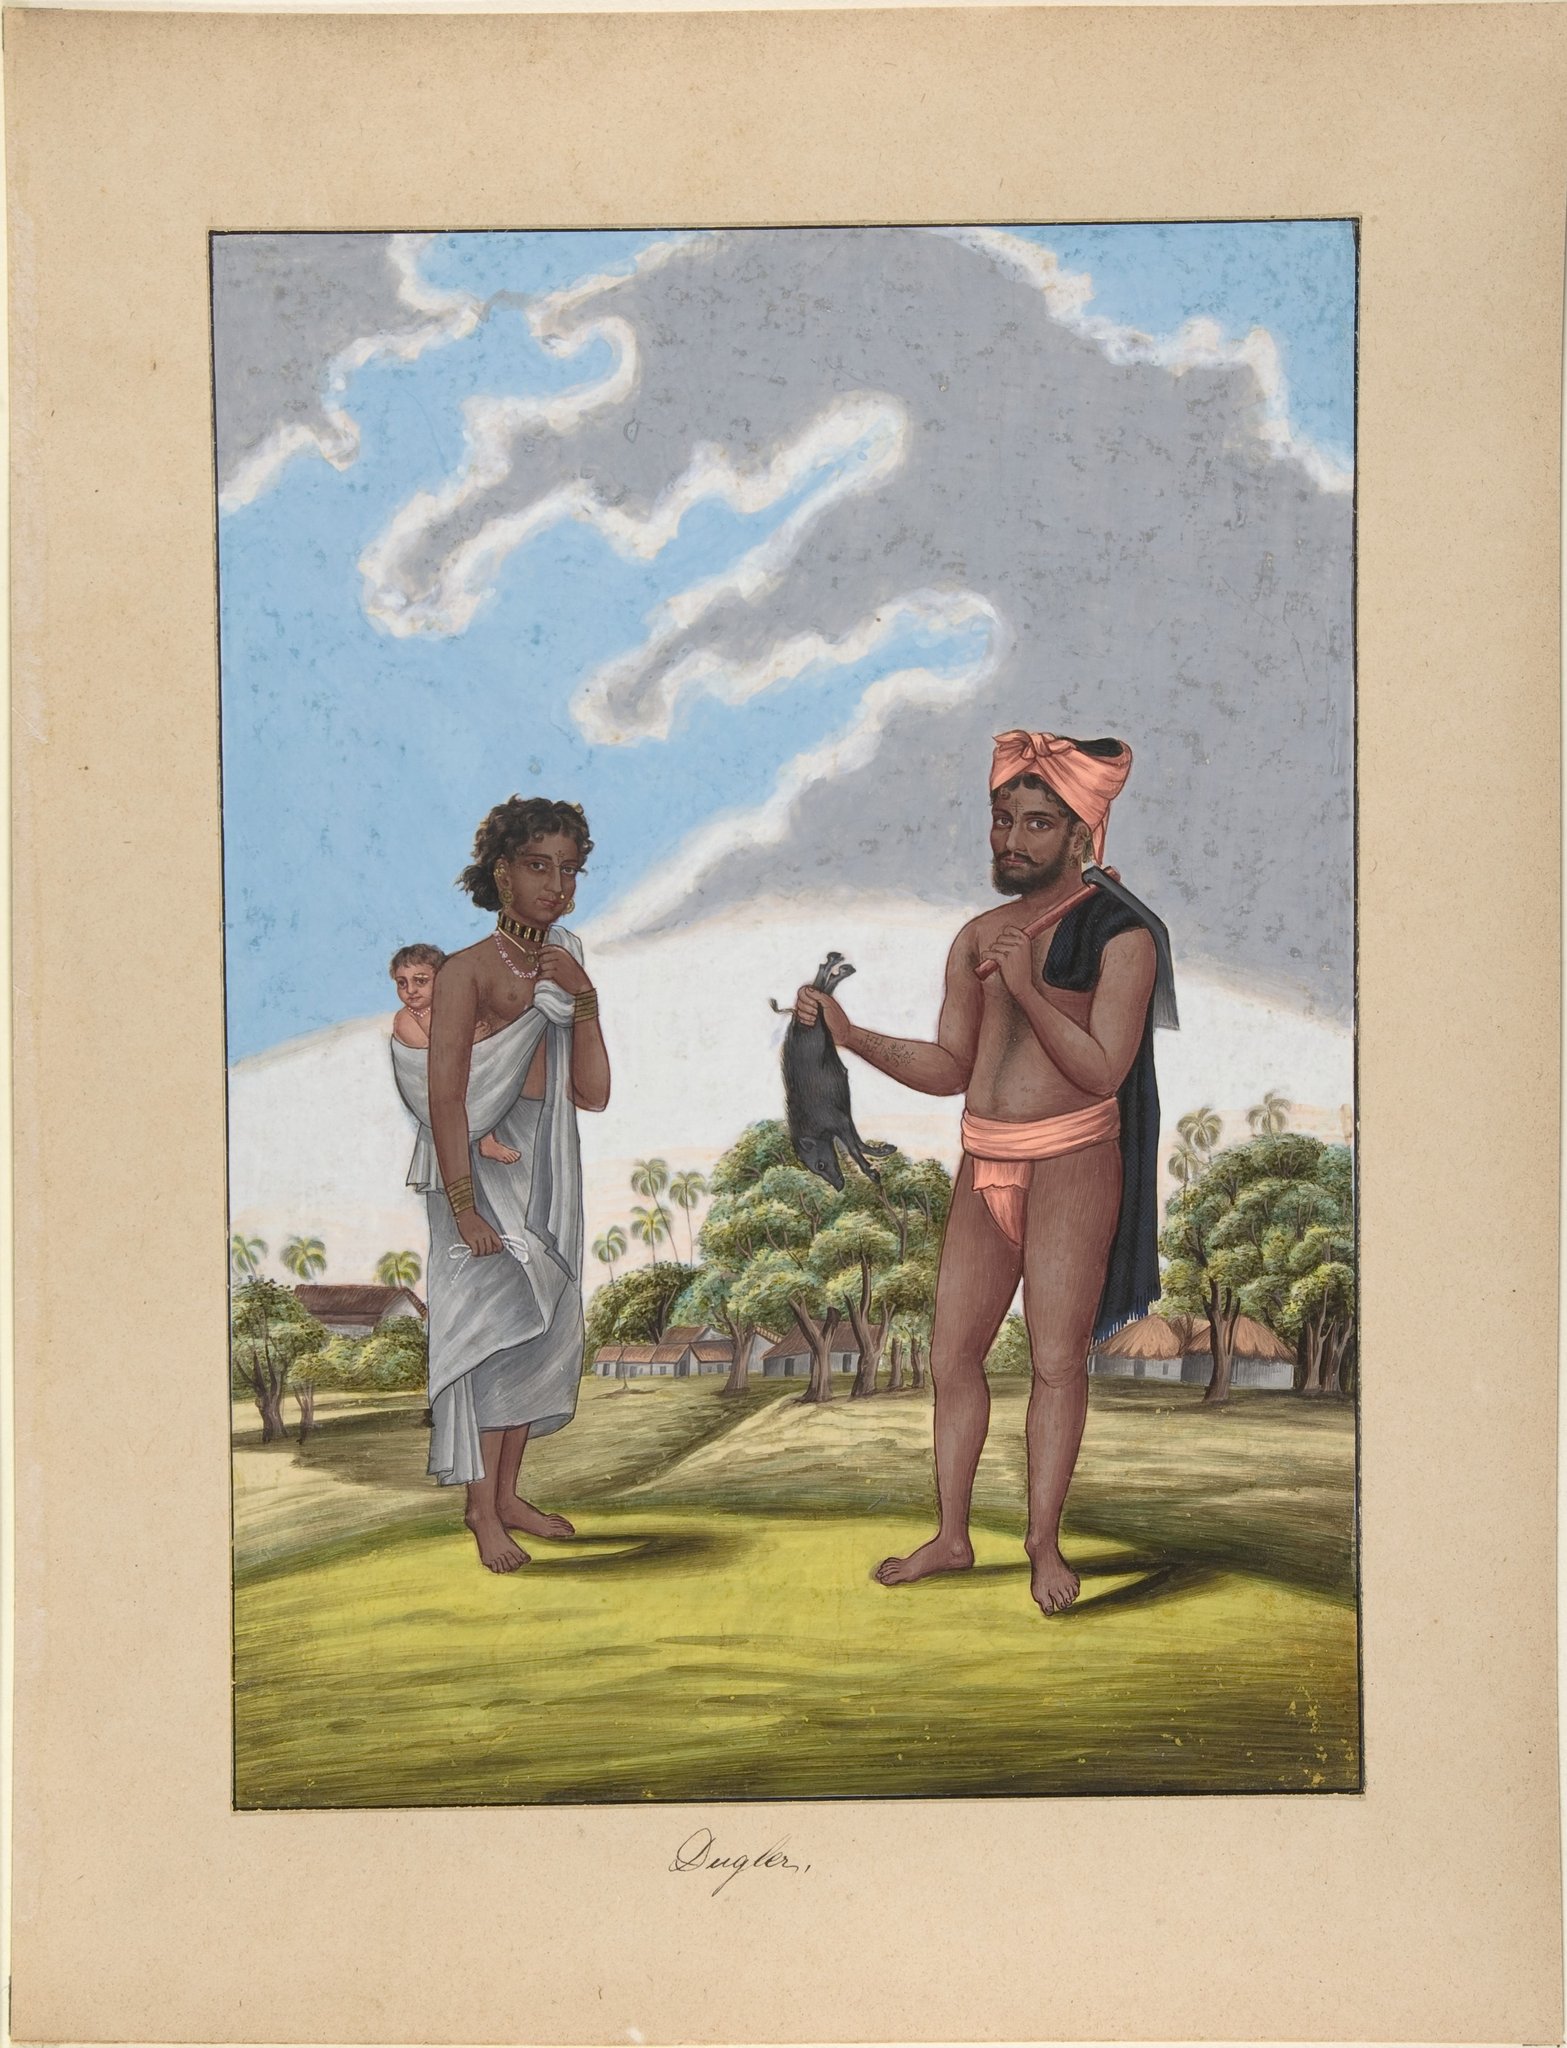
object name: drawing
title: Dugler, from Indian Trades and Castes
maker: anonymous, indian, 19th century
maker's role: artist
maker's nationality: indian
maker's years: 1800-1900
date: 1840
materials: gouache, watercolor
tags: animals,children,men,women